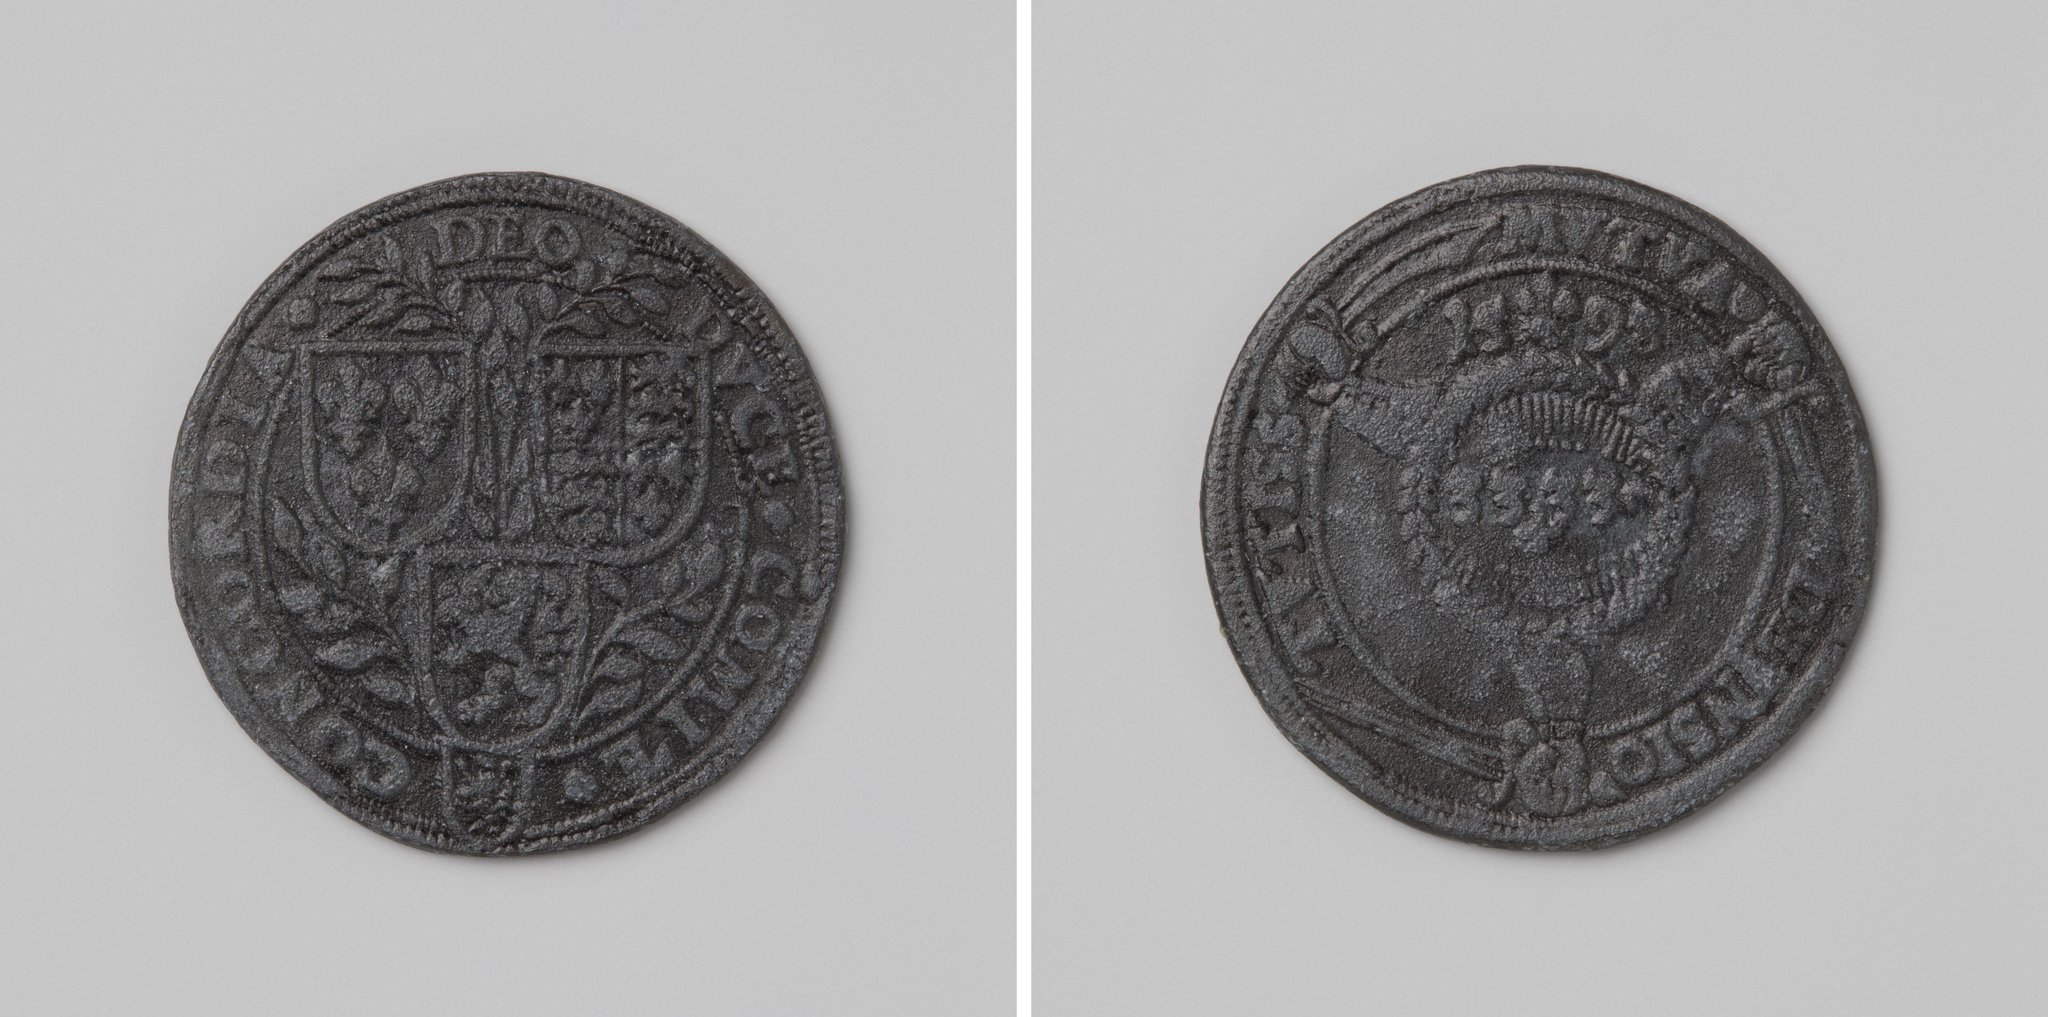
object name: copy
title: Sluiting van het drievoudige verbond tussen Engeland, Frankrijk en de Republiek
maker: Anonymous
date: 1598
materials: lead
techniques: striking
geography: nuremberg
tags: netherlands, zeeland, france, england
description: Vermoedelijk loden penning. Voorzijde: drie wapenschilden aan olijftak binnen omschrift. Keerzijde: naam Jehovah in Hebreeuws schrift in stralenkrans en ovaal; daaromheen drie armen met zwaard onder jaartal binnen omschrift. Vermoedelijk een kopie.